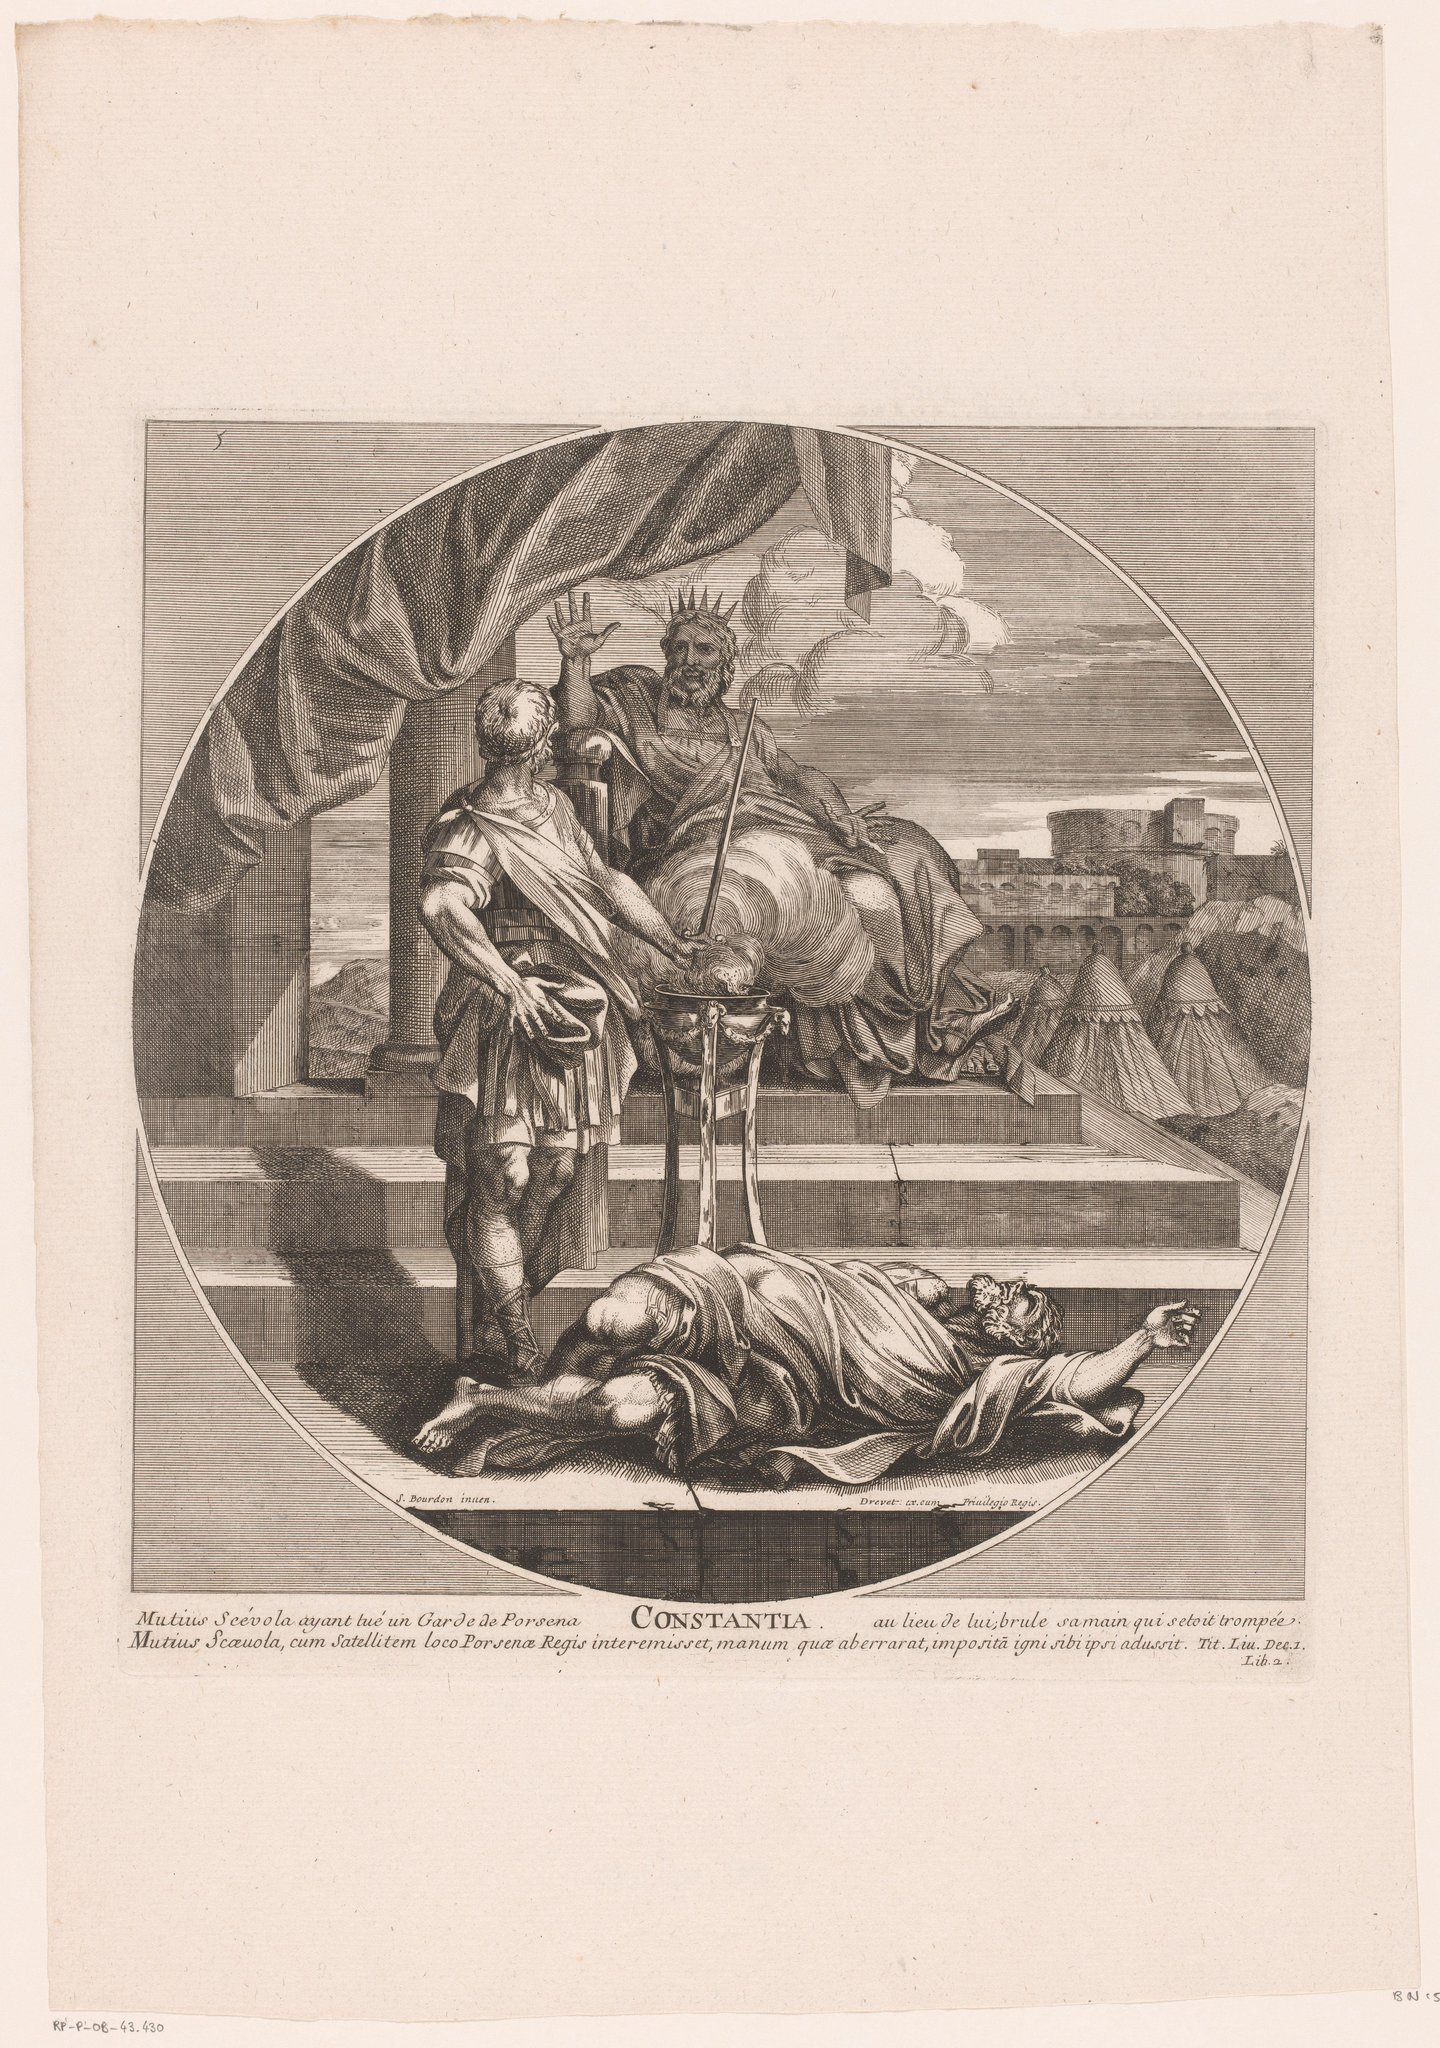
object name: print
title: Les Vertus et les Arts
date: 1663-1738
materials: paper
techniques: engraving, etching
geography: france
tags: (story of) gaius mucius scaevola, constancy, tenacity; 'costanza', 'tenacità' (ripa), (story of) porsena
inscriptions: collector's mark: Lugt 2228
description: Maakt deel uit van een veertiendelige serie opgedeeld in twee reeksen, met als onderwerp de zeven vrije kunsten en deugden naar schilderijen door Sébastien Bourdon. De schilderijen werden in 1663 vervaardigd voor de Grande Galerie van het Hôtel de Bretonvilliers te Parijs.